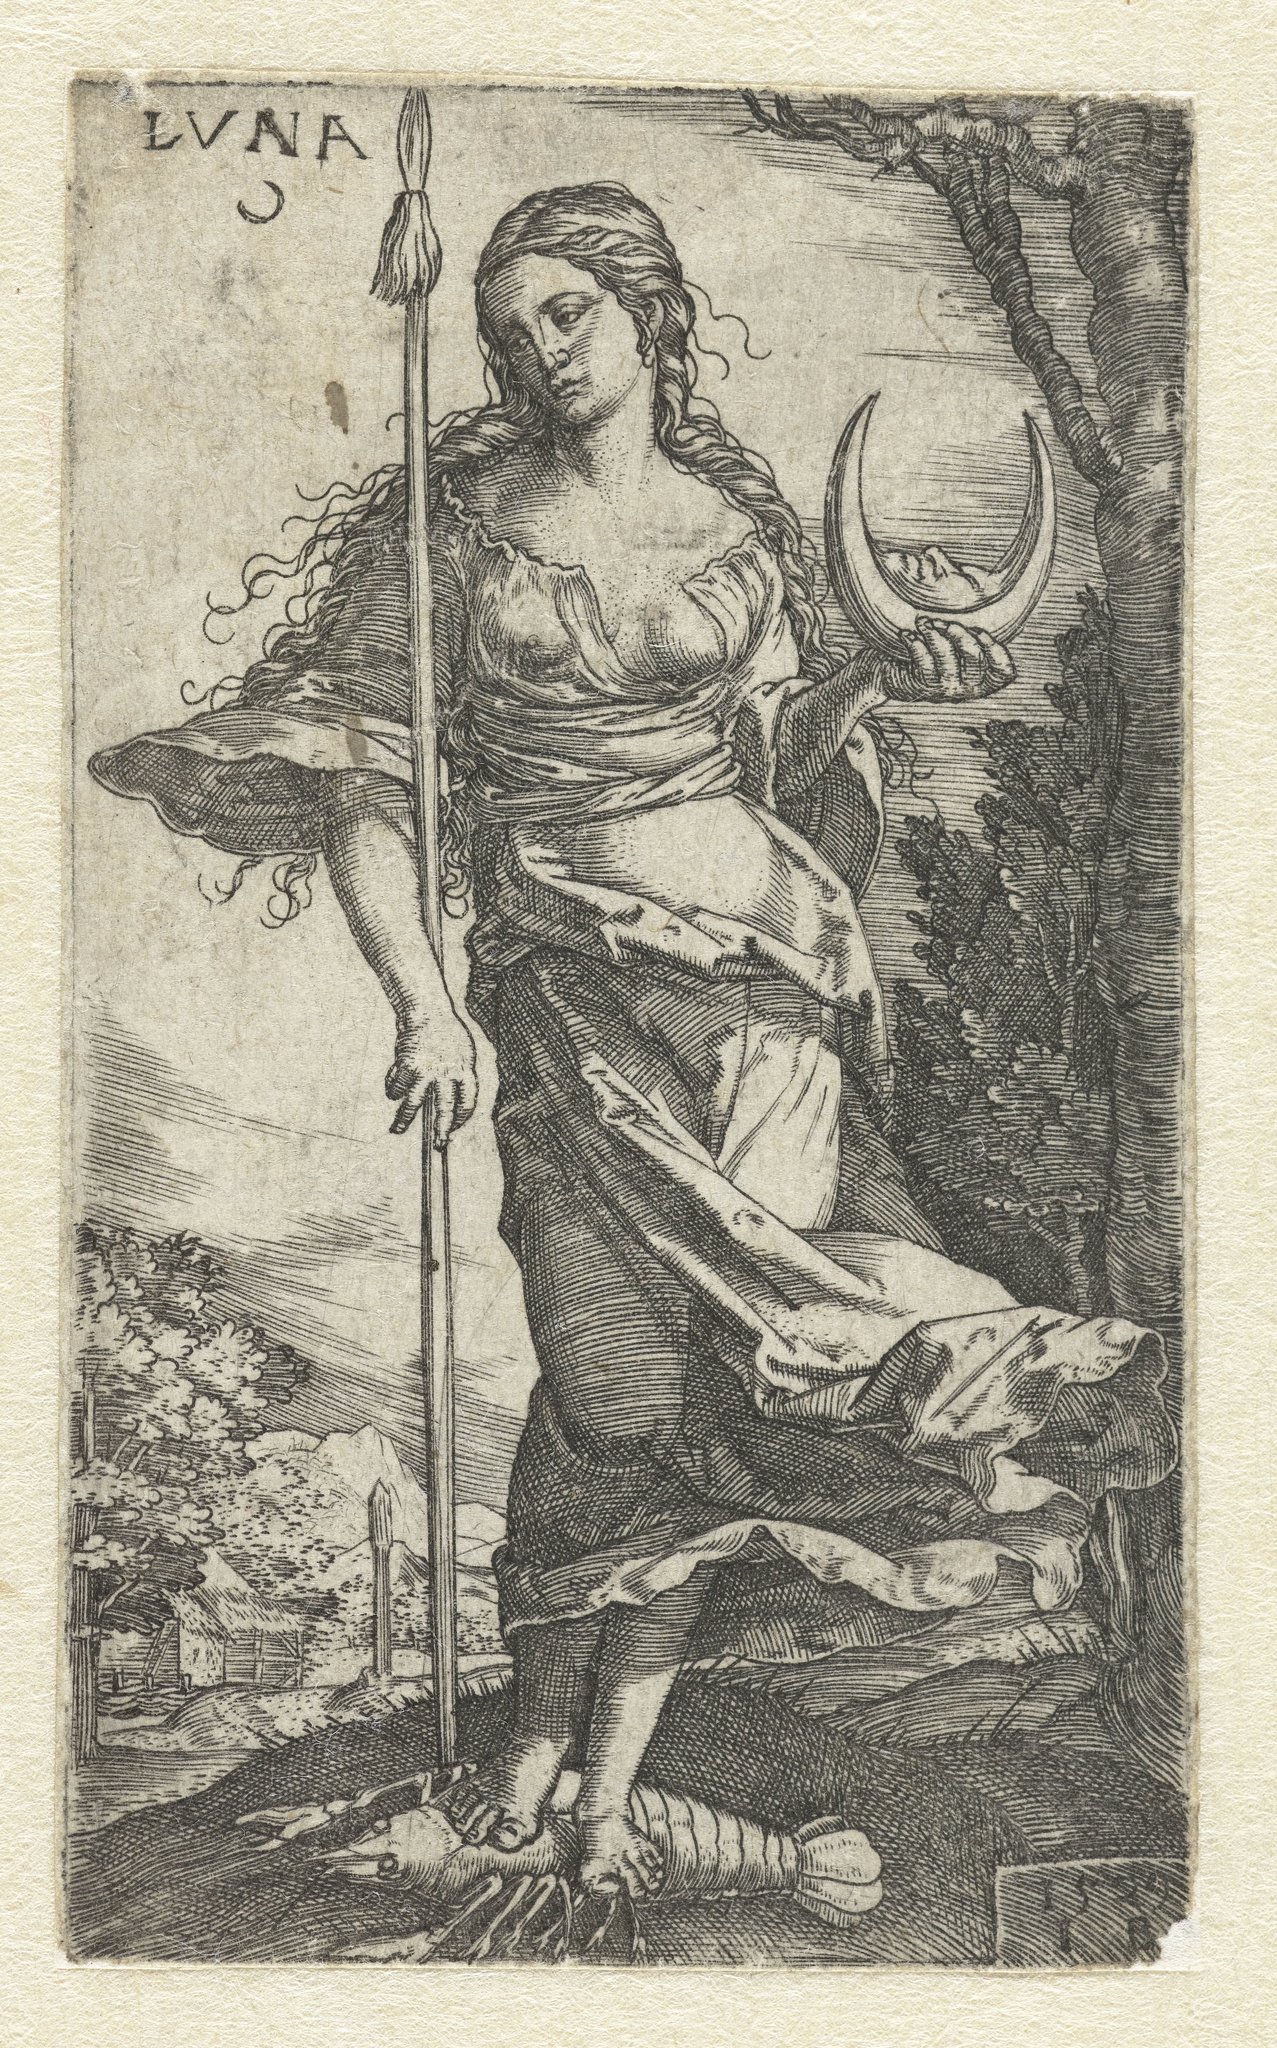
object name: print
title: Diana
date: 1529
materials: paper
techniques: engraving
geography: germany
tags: diana as moon-goddess, i.e. luna (selene)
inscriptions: collector's mark: ‘Hinloopen’ Lugt 11, collector's mark: ‘Hinloopen’ Lugt 2228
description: Diana als de maangodin Luna, staand op het steerenbeeld kreeft, een staf in haar rechterhand en een maansikkel in heet linker.